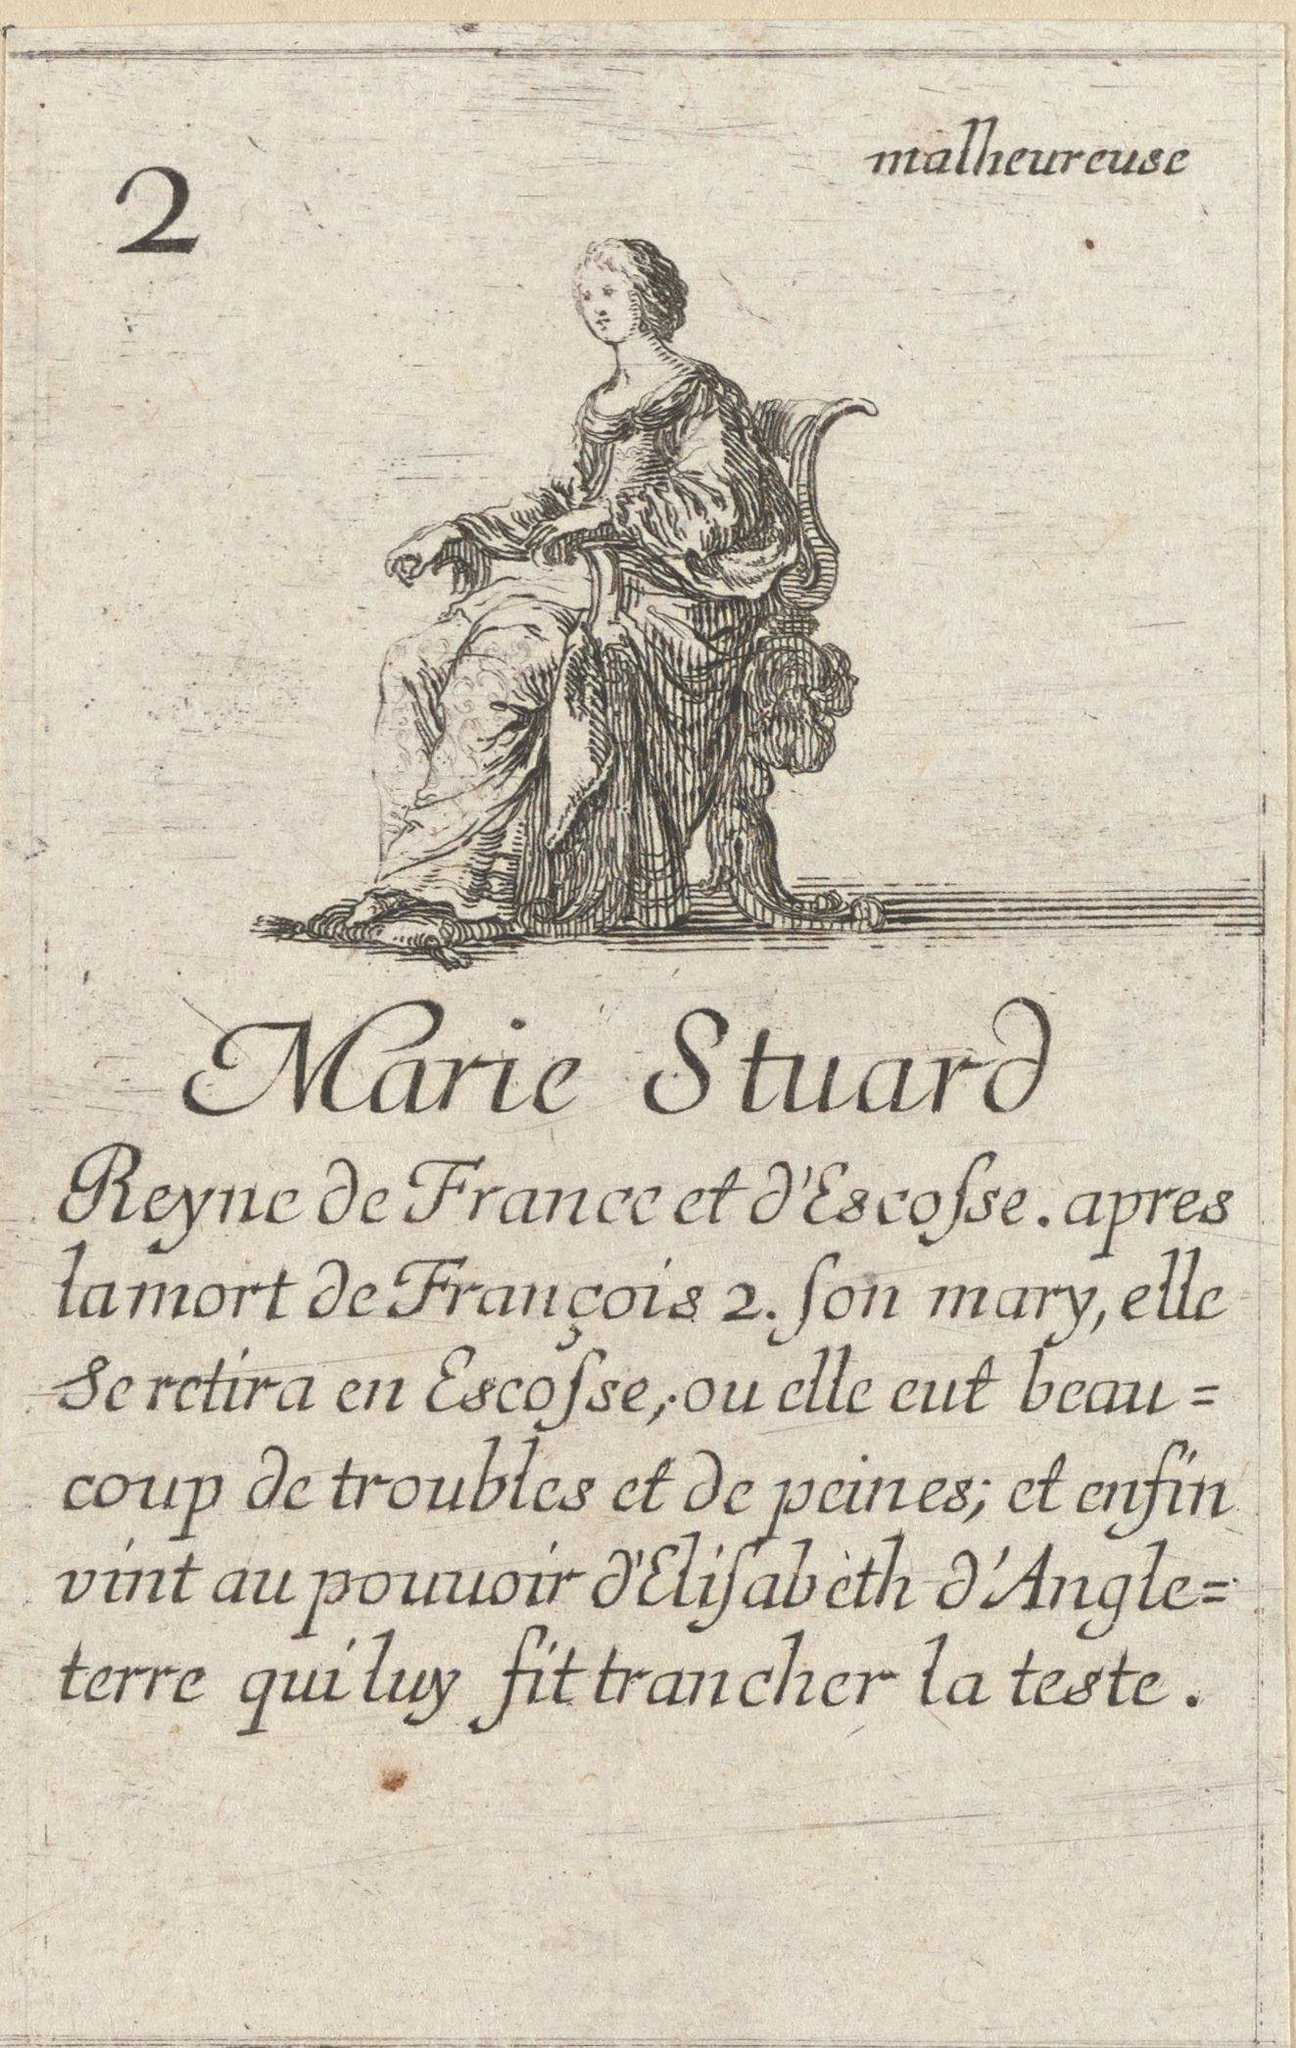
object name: playing card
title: Marie Stuard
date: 1620-1664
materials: paper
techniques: etching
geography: paris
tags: ruler, sovereign - bb - female ruler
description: Deze prent maakt deel uit van een kaartspel met 52 kaarten met voorstellingen van beroemde koninginnen. De serie is uitgedacht door Jean Desmarests de Saint-Sorlin in opdracht van Kardinaal Mazarin. Het kaartspel werd gemaakt voor de jonge Lodewijk XIV, samen met het Jeu des Fables, Jeu de la Géographie en Jeu des Rois de France.